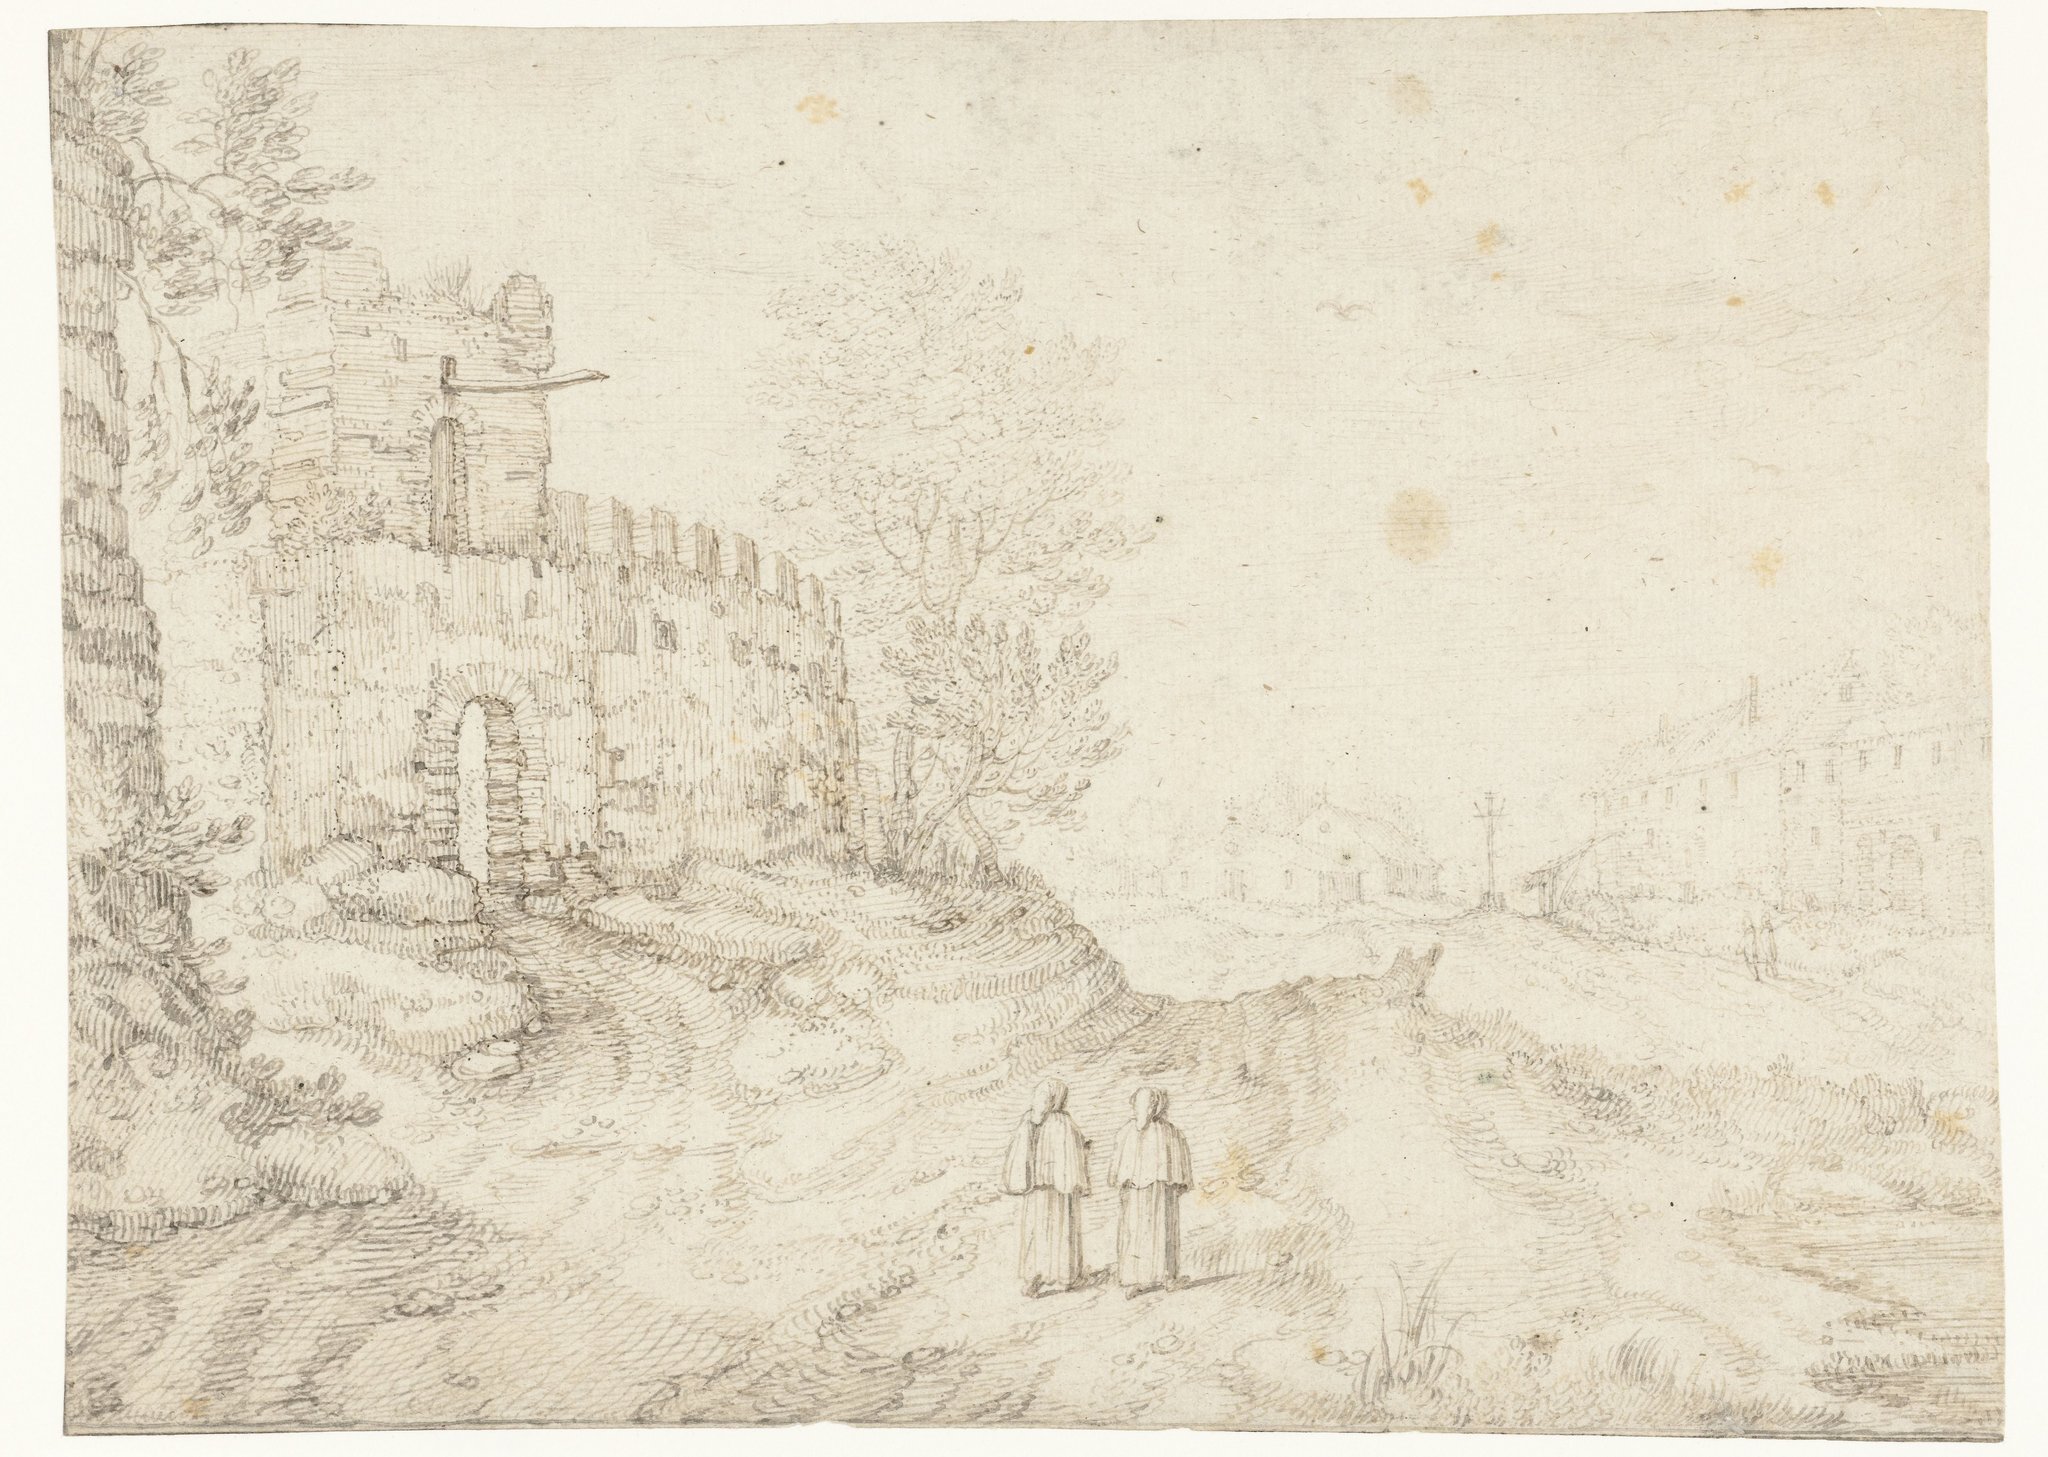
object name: drawing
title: Landweg langs stadsmuur en klooster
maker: Anonymous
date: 1575-1599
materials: ink, paper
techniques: pen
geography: low countries